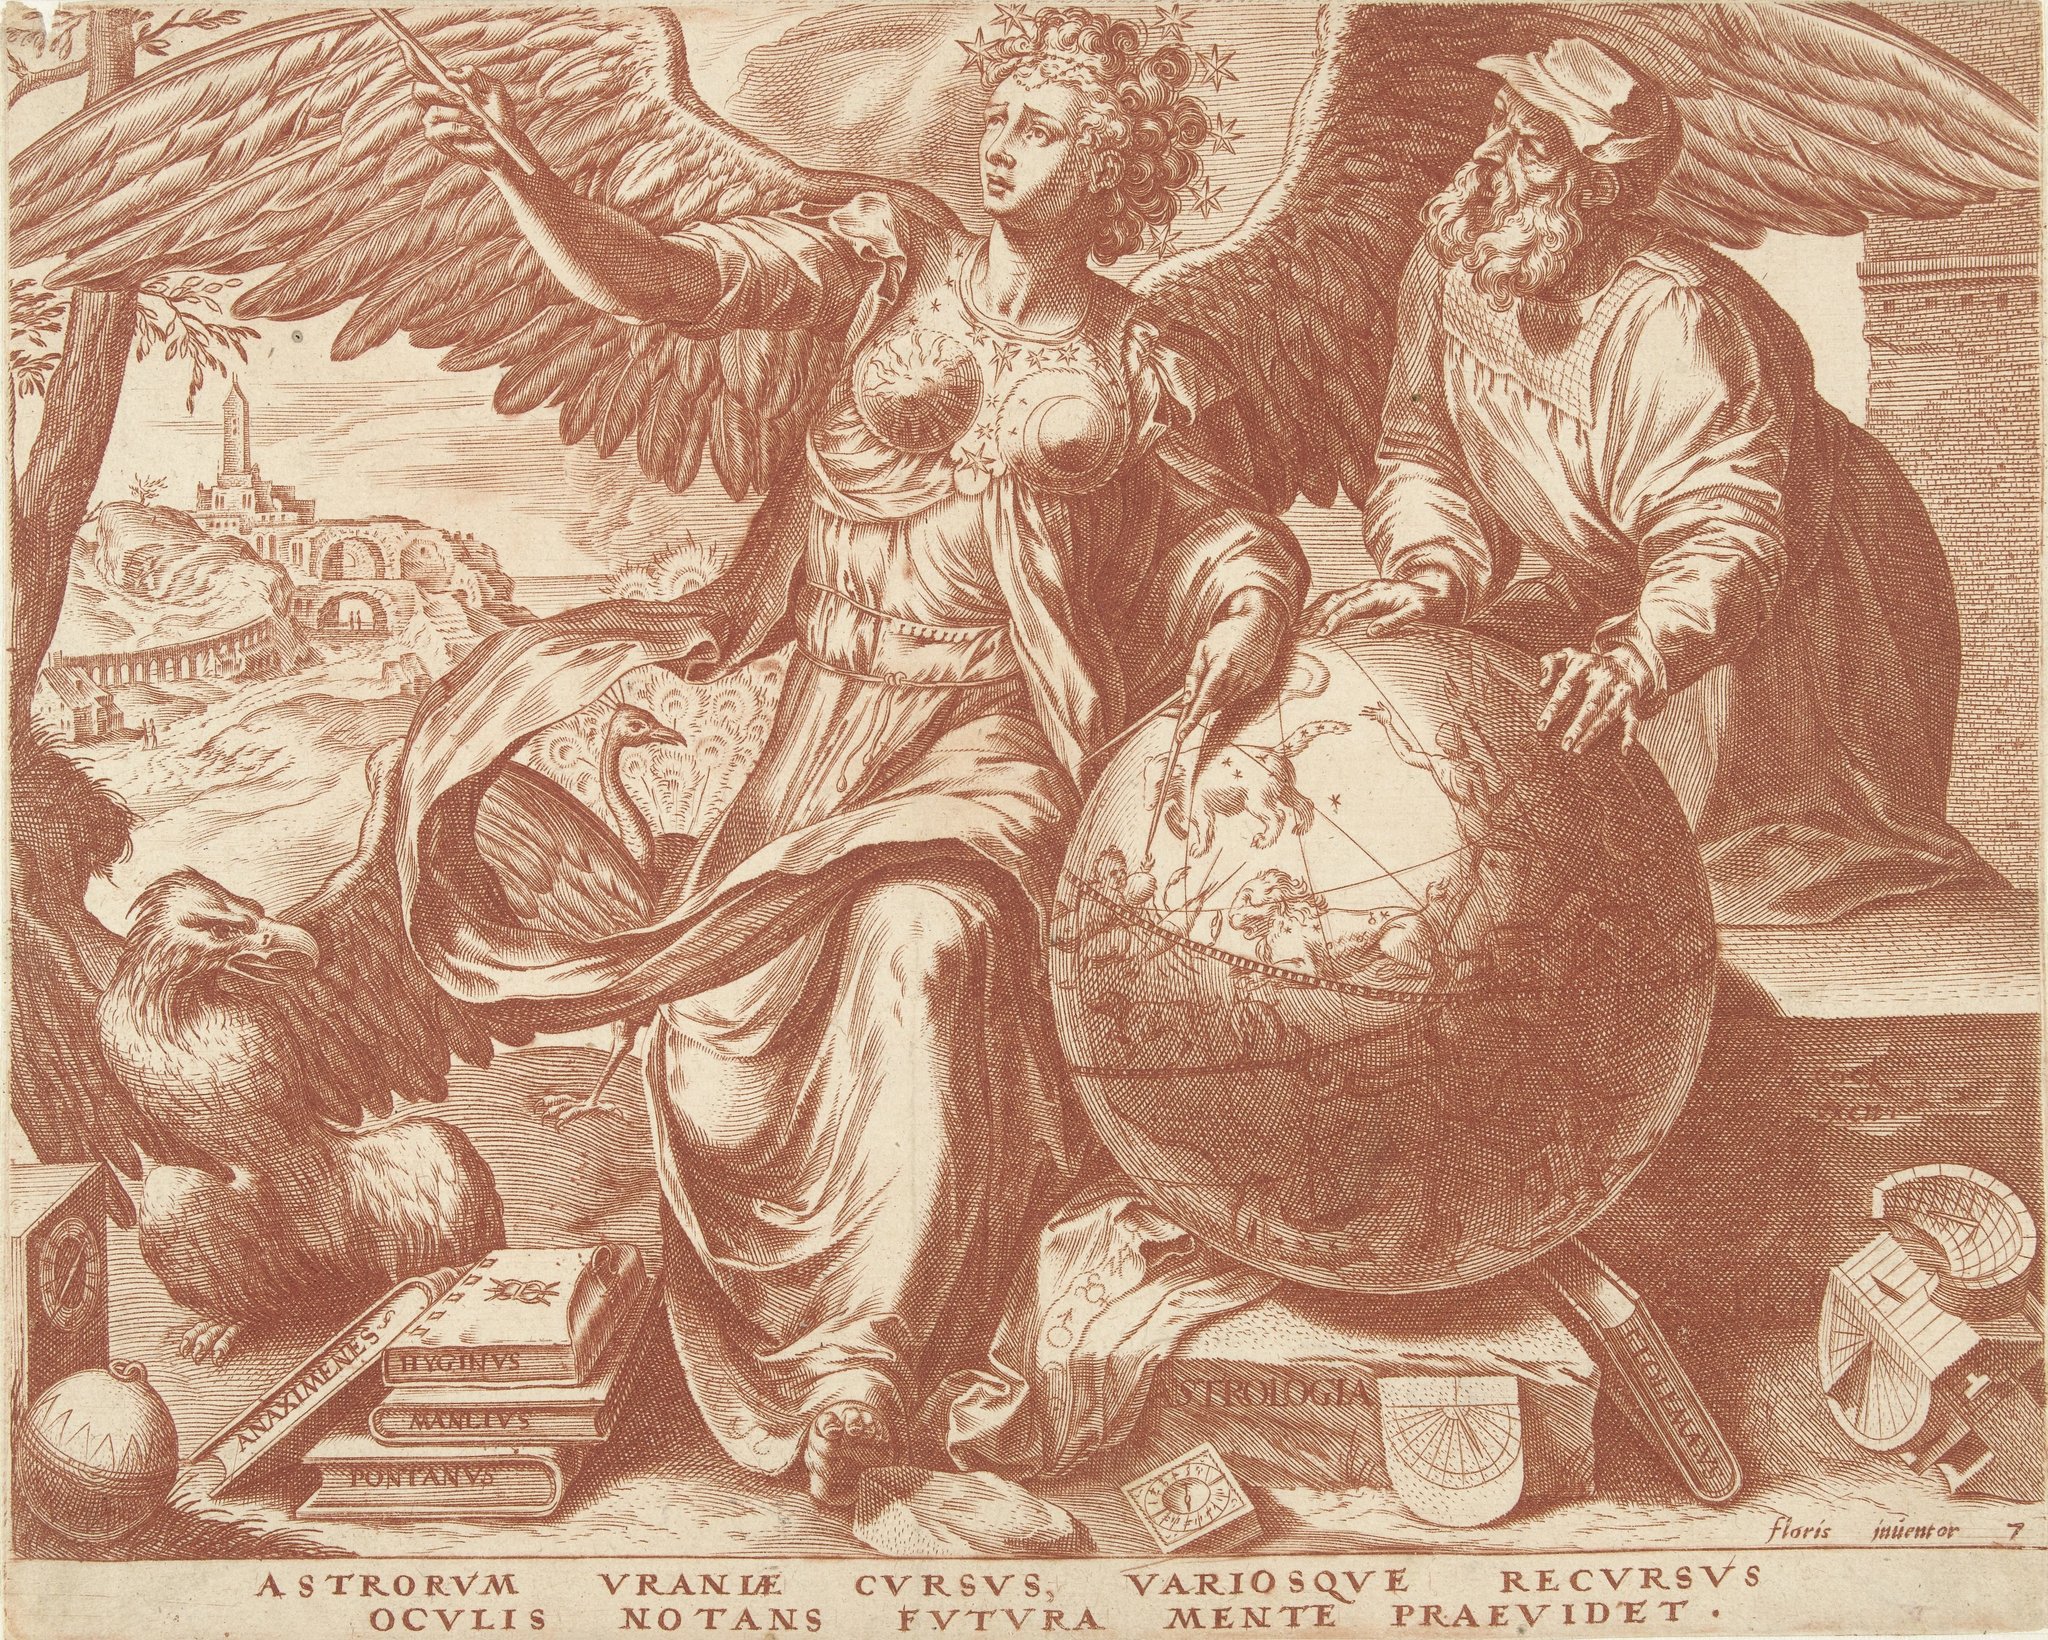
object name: print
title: Astrologia (Sterrenkunde)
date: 1565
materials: paper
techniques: printing, engraving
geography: antwerp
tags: 'astronomia' (~ quadrivium); 'astronomia' (ripa)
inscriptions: collector's mark: Lugt 240, caption:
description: Astrologia , een gevleugelde vrouw met een sterrenkrans om het hoofd, meet de afstand tussen de sterrenbeelden met een passer op een hemelglobe. Haar blik is visionair richting hemel gericht. Een oude man met baard die naast haar staat kijkt dezelfde kant op. Op de grond liggen boeken en astrologische instrumenten. Achter Astrologia zit een pauw en rechts naast haar staat een adelaar.